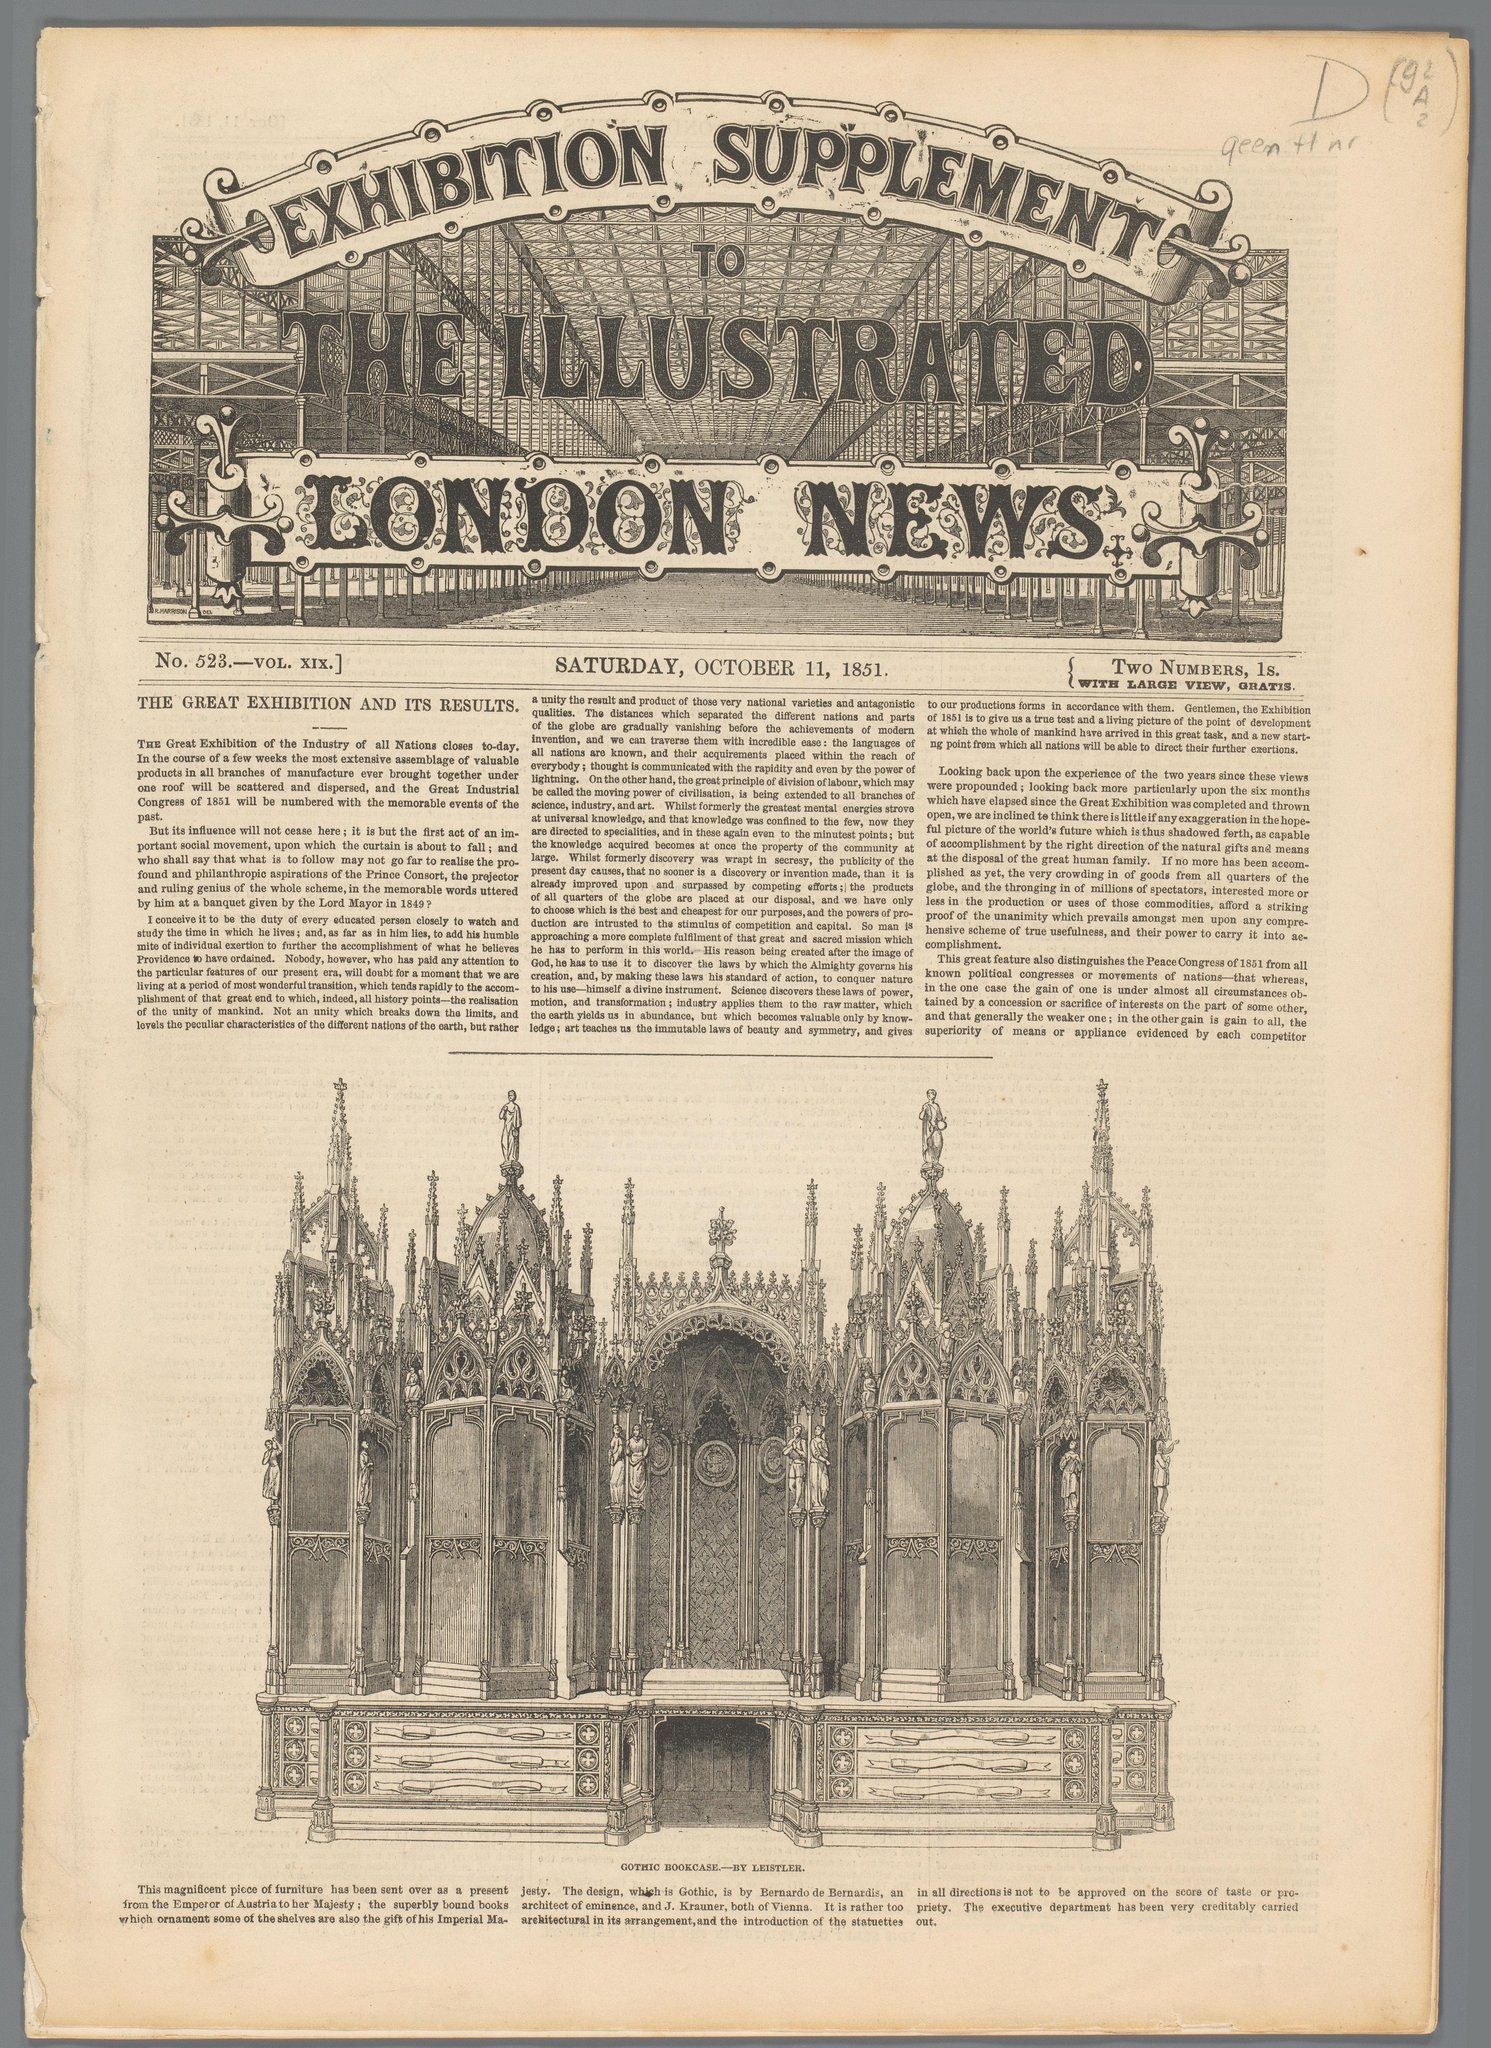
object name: print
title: Exhibition Supplement, bijlage bij de Illustrated London News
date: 1851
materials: paper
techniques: letterpress printing, engraving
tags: piece of sculpture, reproduction of a piece of sculpture, horse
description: Exhibition Supplement to the Illustrated London News gewijd aan de Wereldtentoonstelling van 1851 te Londen met diverse houtgravures, waaronder een houtgravure naar een daguerreotypie van twee sculptuurgroepen met paarden door Antoine Claudet op pagina 469.